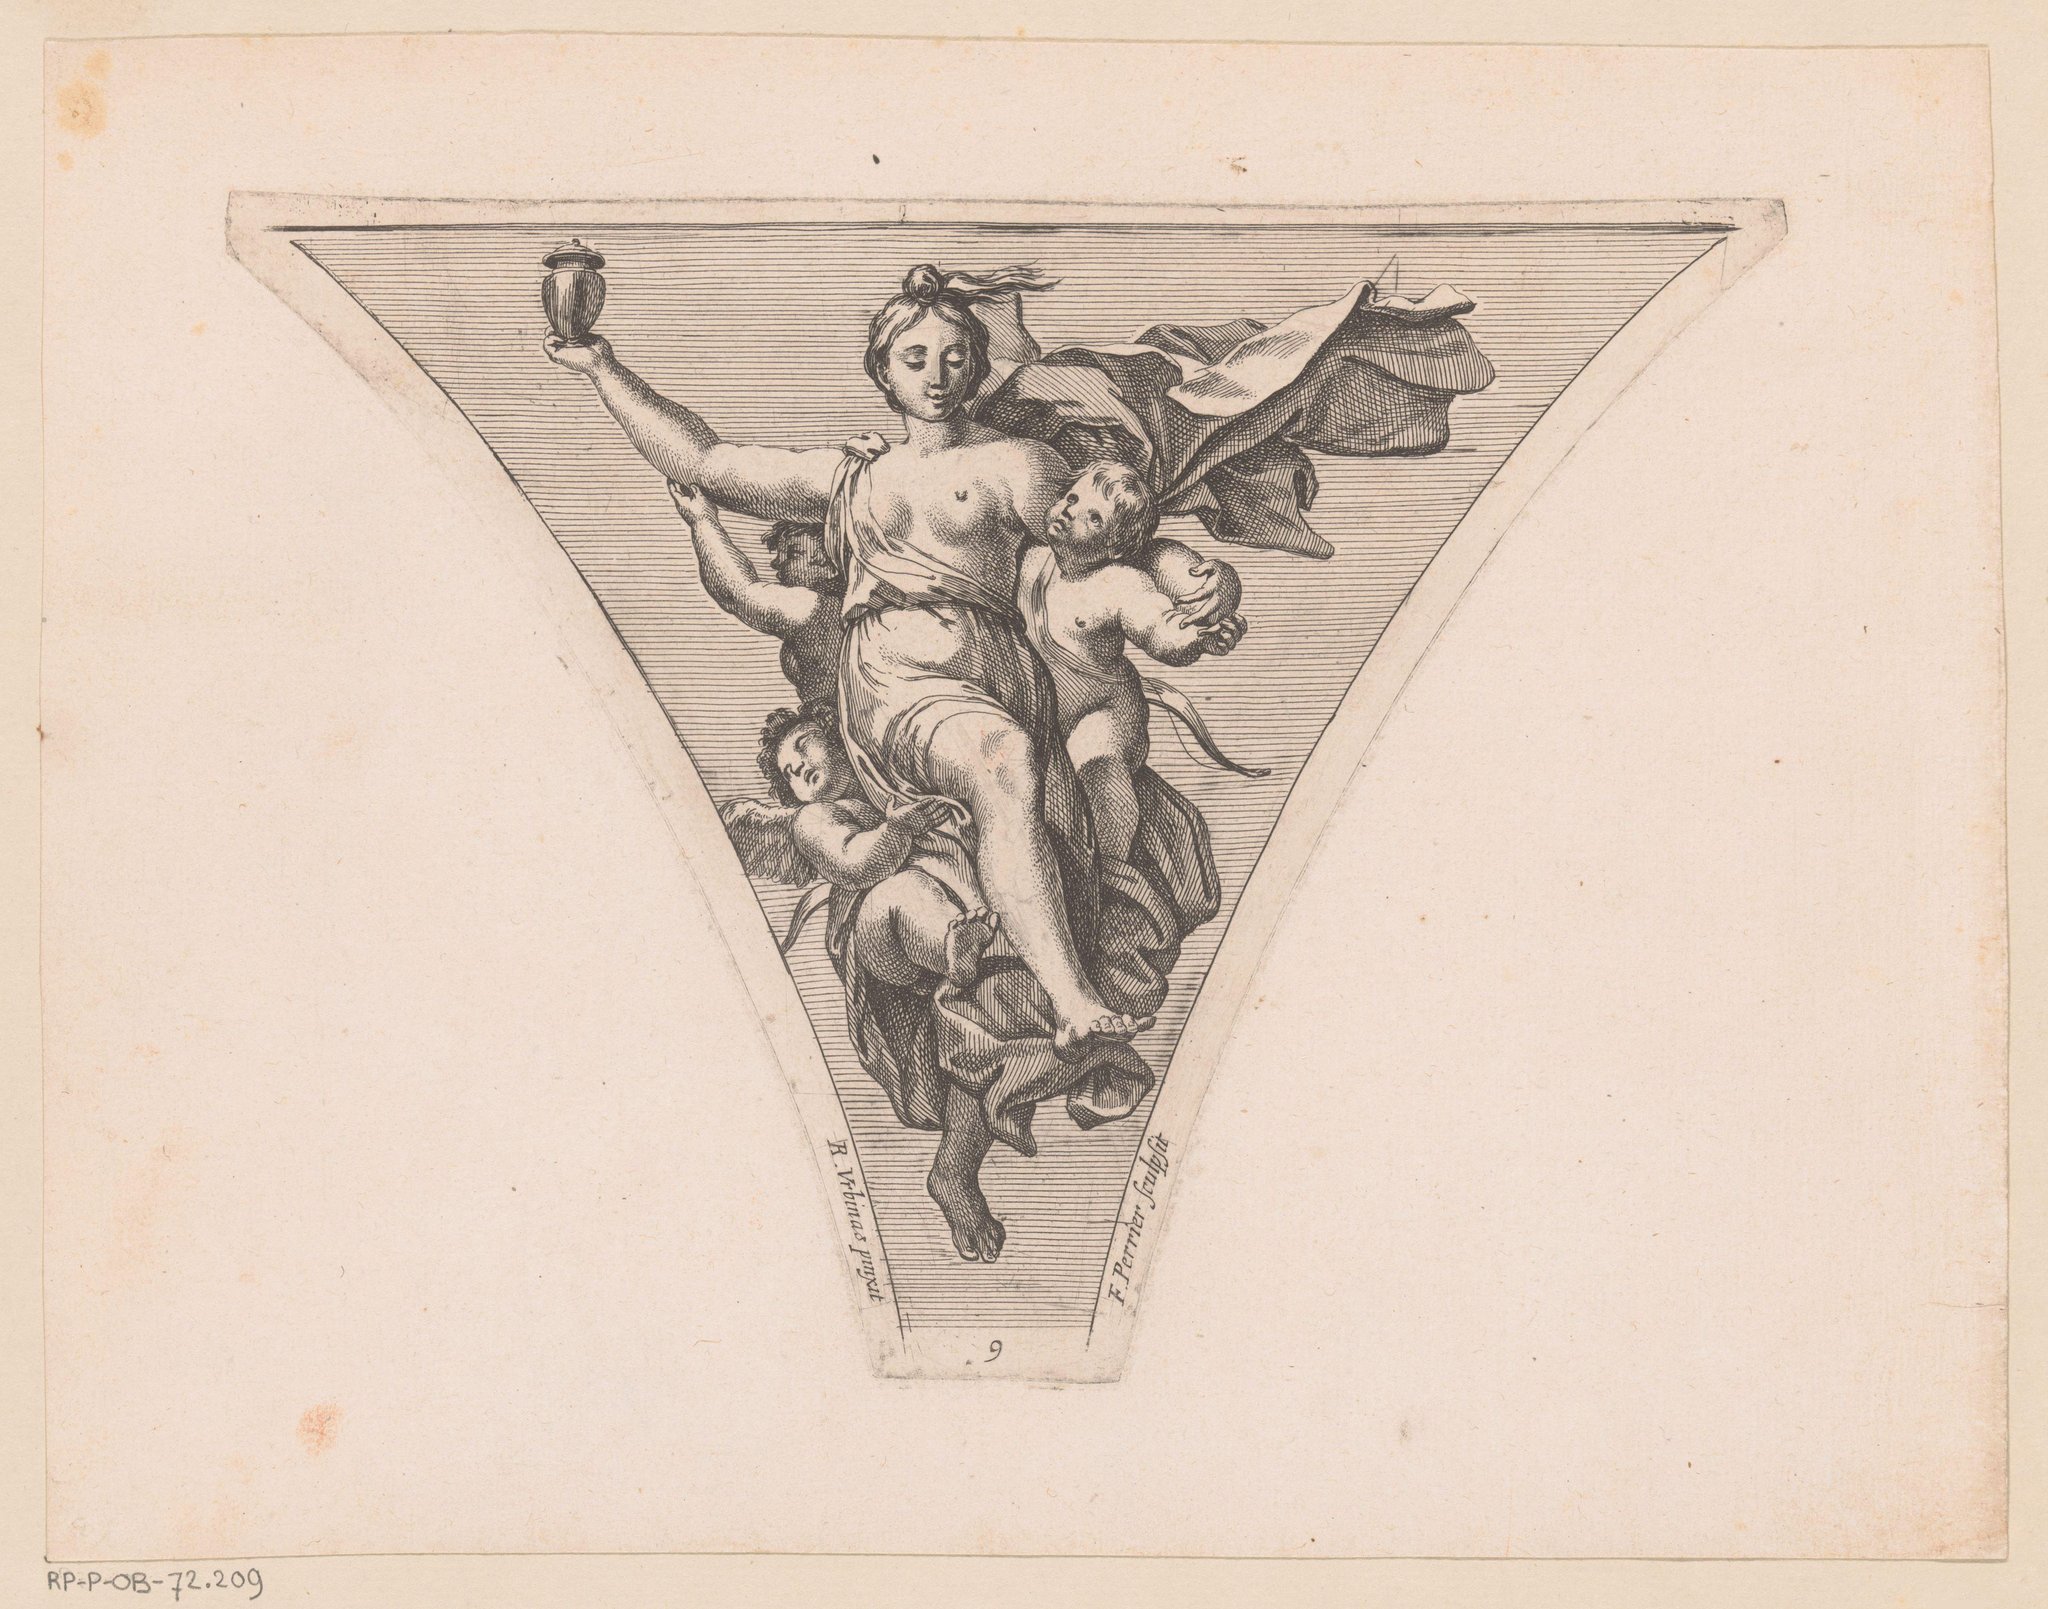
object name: print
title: Fresco's van Rafaël in de Villa Farnesina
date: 1624-1649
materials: paper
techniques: etching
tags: the eagle of jupiter fetches water from the styx with psyche's jar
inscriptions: collector's mark: Lugt 240